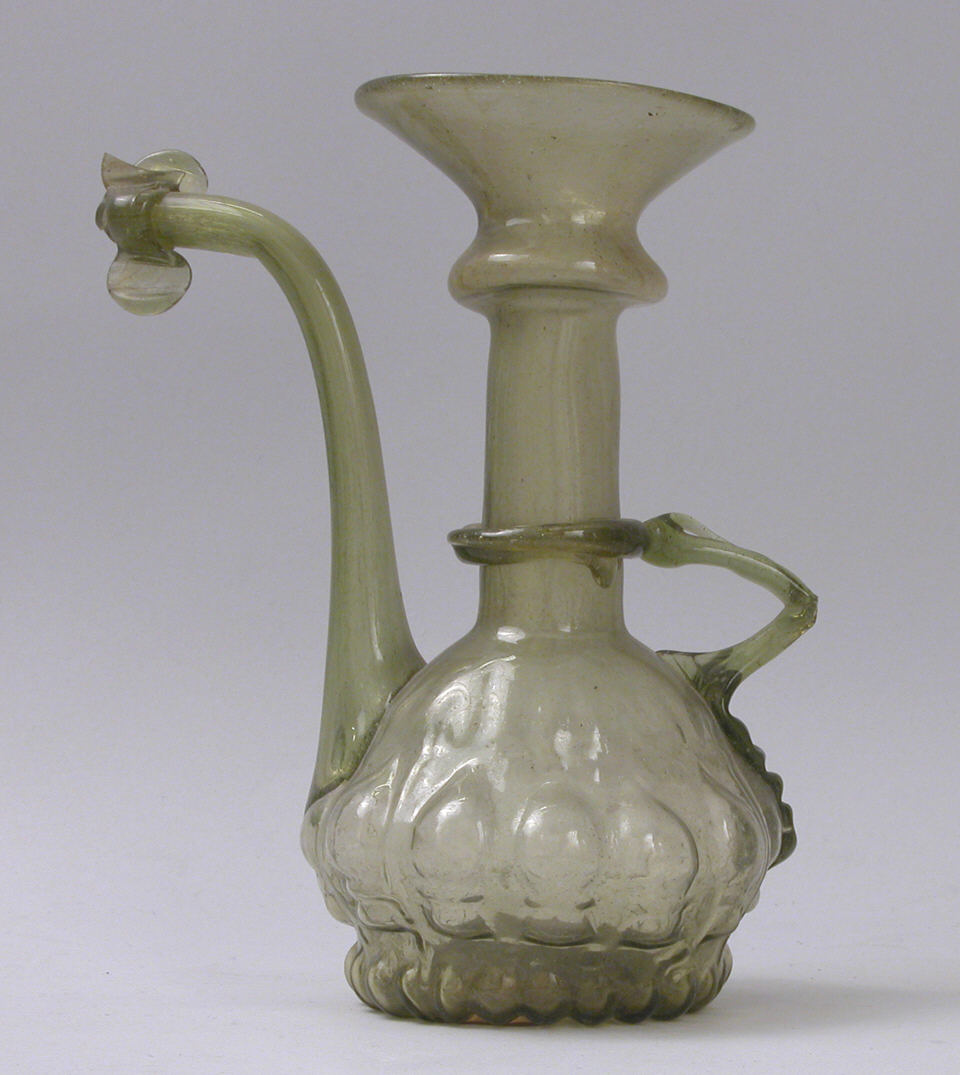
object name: ewer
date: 1701-1900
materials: glass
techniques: glassblowing, tooling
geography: iran